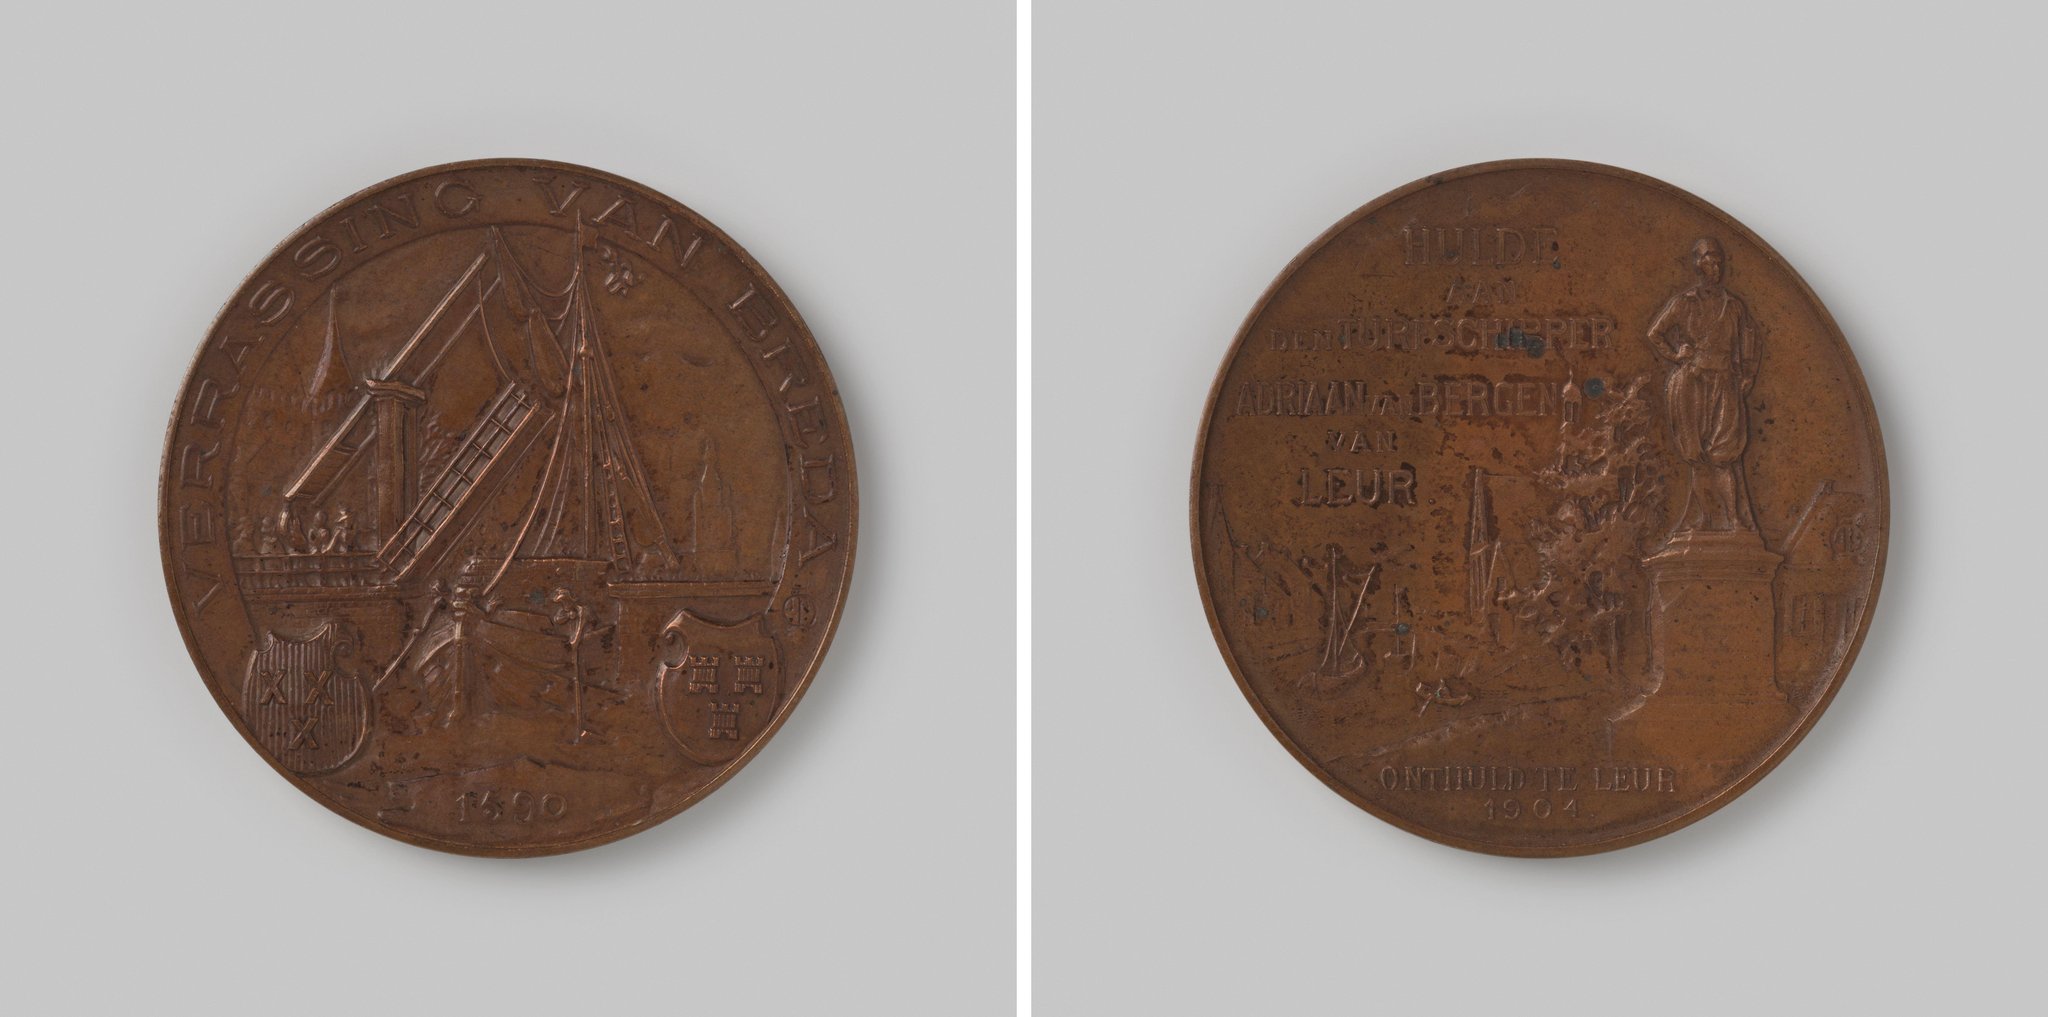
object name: history medal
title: Oprichting van het standbeeld van Adriaan van Bergen, schipper op het Turfschip van Breda, te Leur 1904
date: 1904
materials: copper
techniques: striking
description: Koperen penning, op de voorzijde een turfschip dat door een geopende brug vaart, onderaan de wapenschilden van Breda en Leur en het jaartal 1590, met omschrift, op de keerzijde het standbeeld van Van Bergen in Leur met onder en boven tekst.